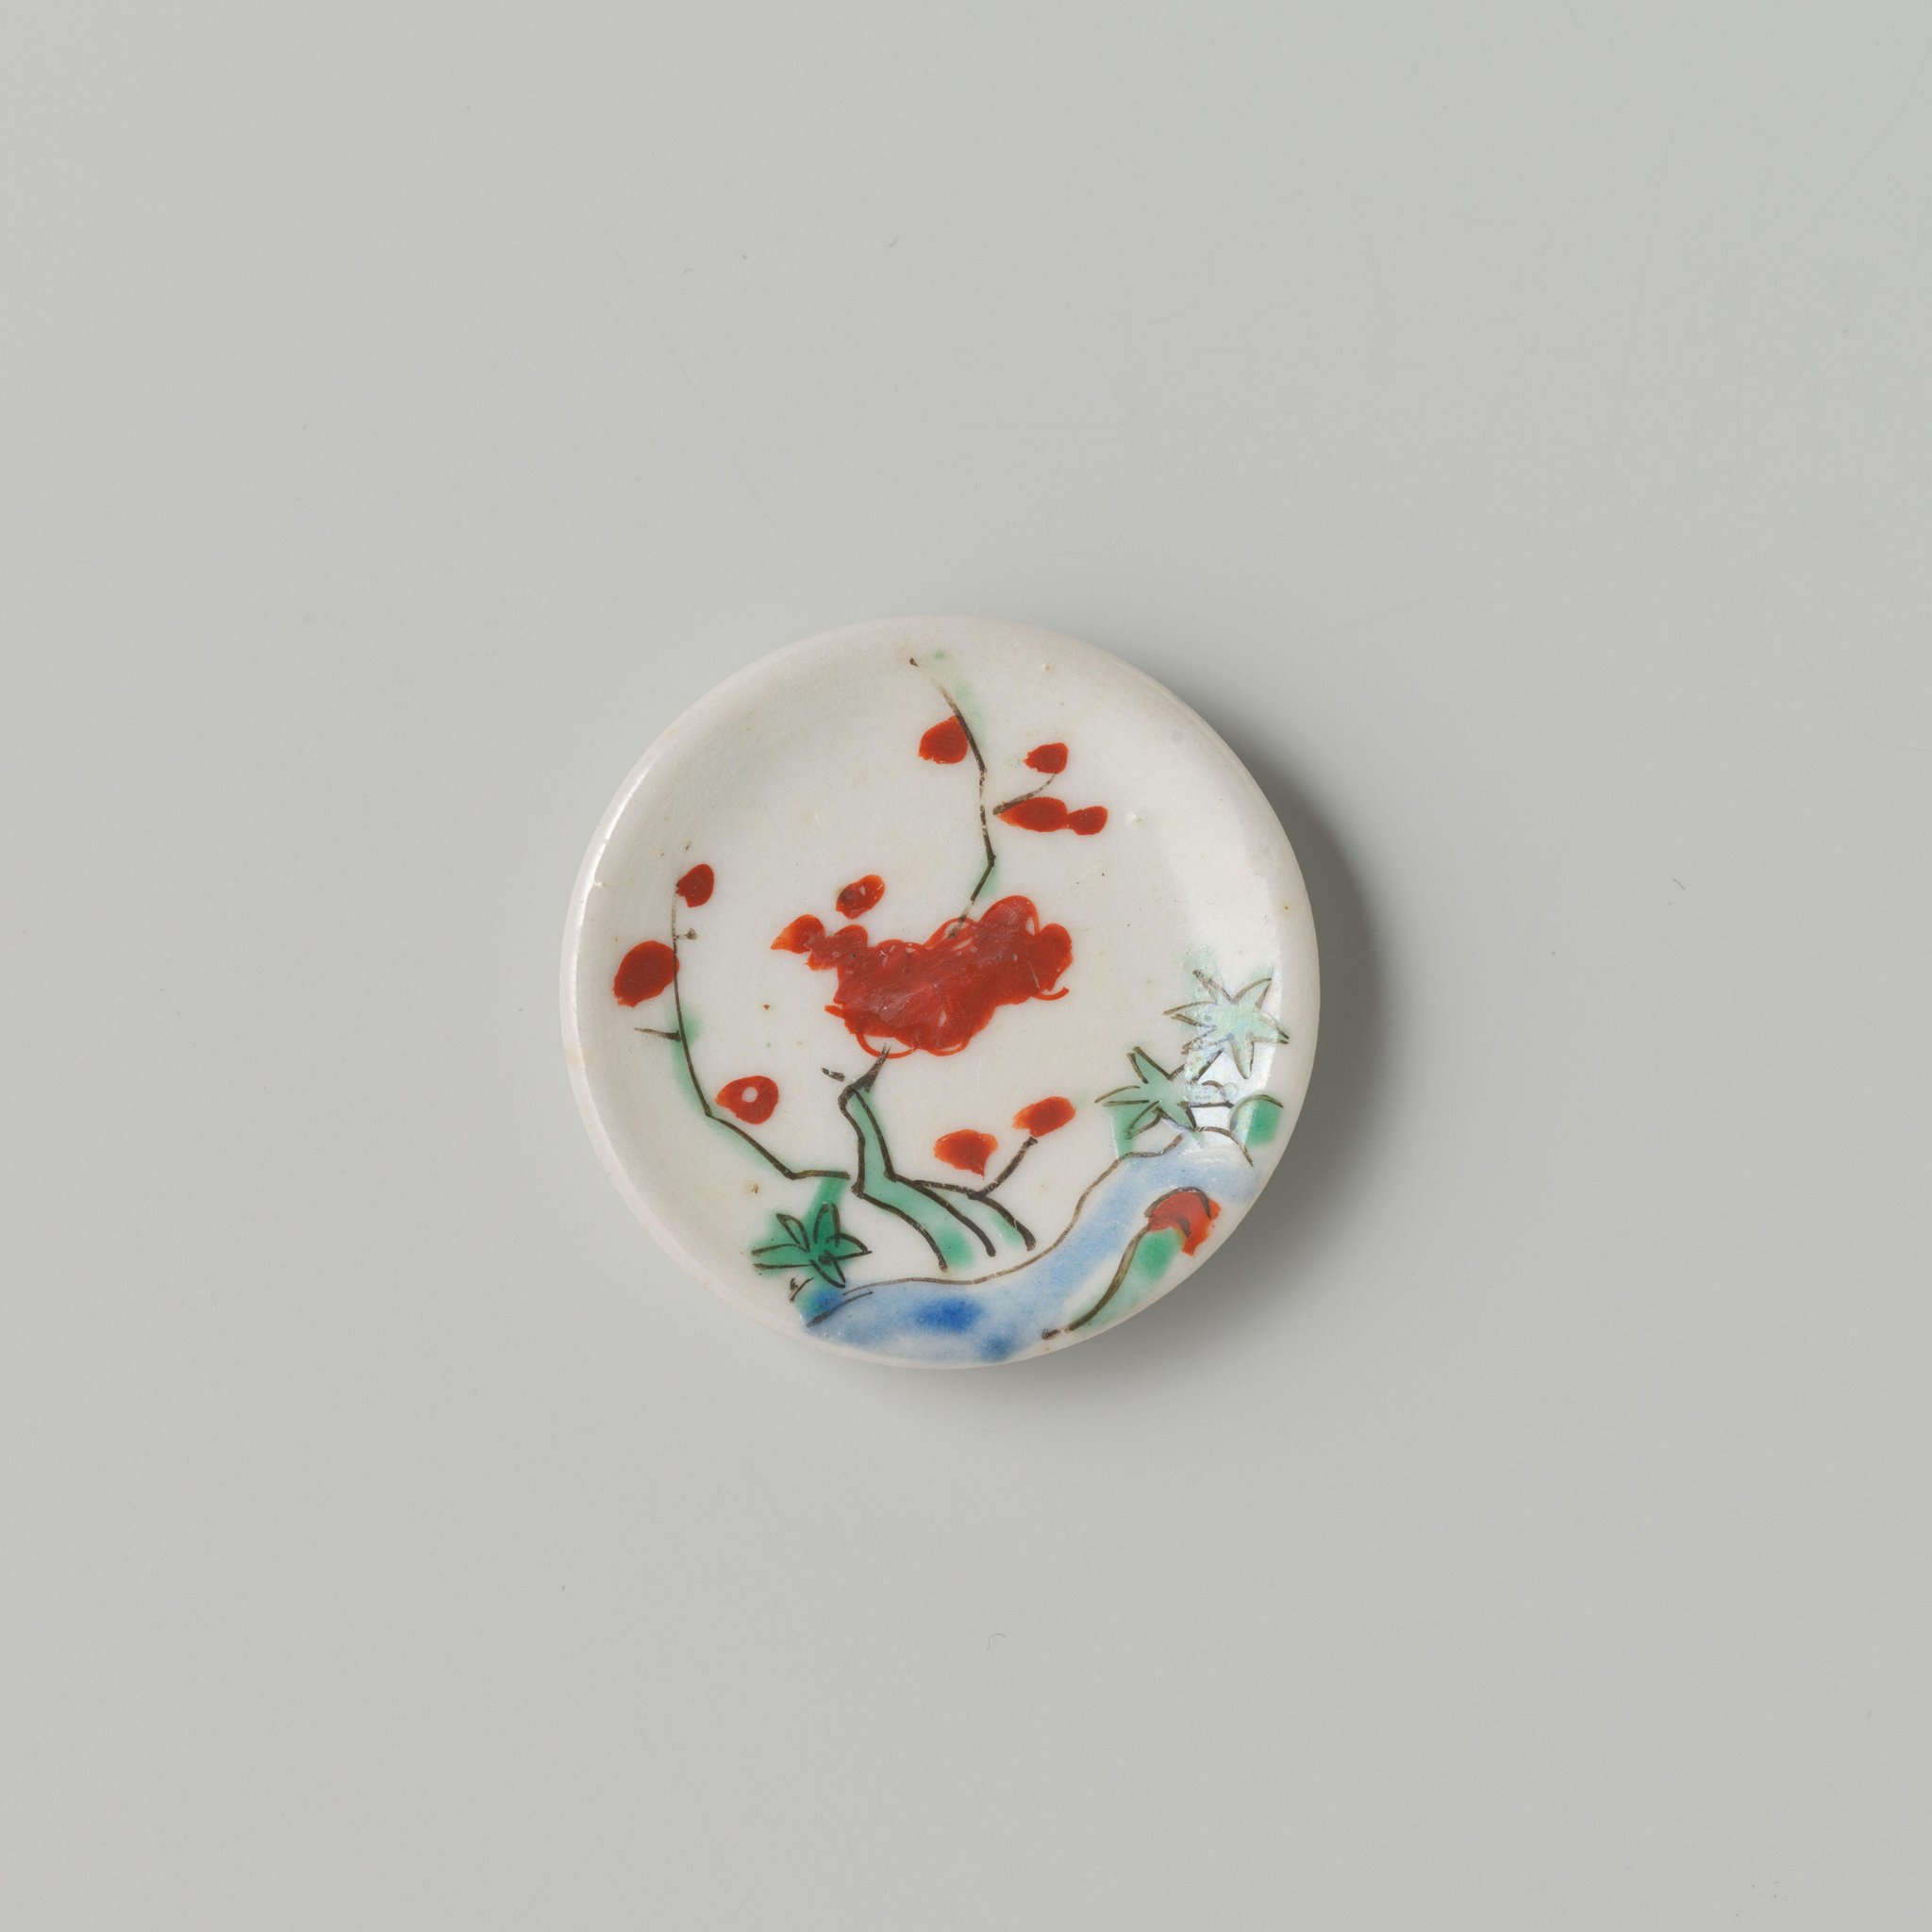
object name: platter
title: Schotel van porselein met veelkleurige decoratie in Kakiemonstijl (bloesemtakken en rotsje)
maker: Anonymous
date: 1690-1710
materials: porcelain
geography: arita